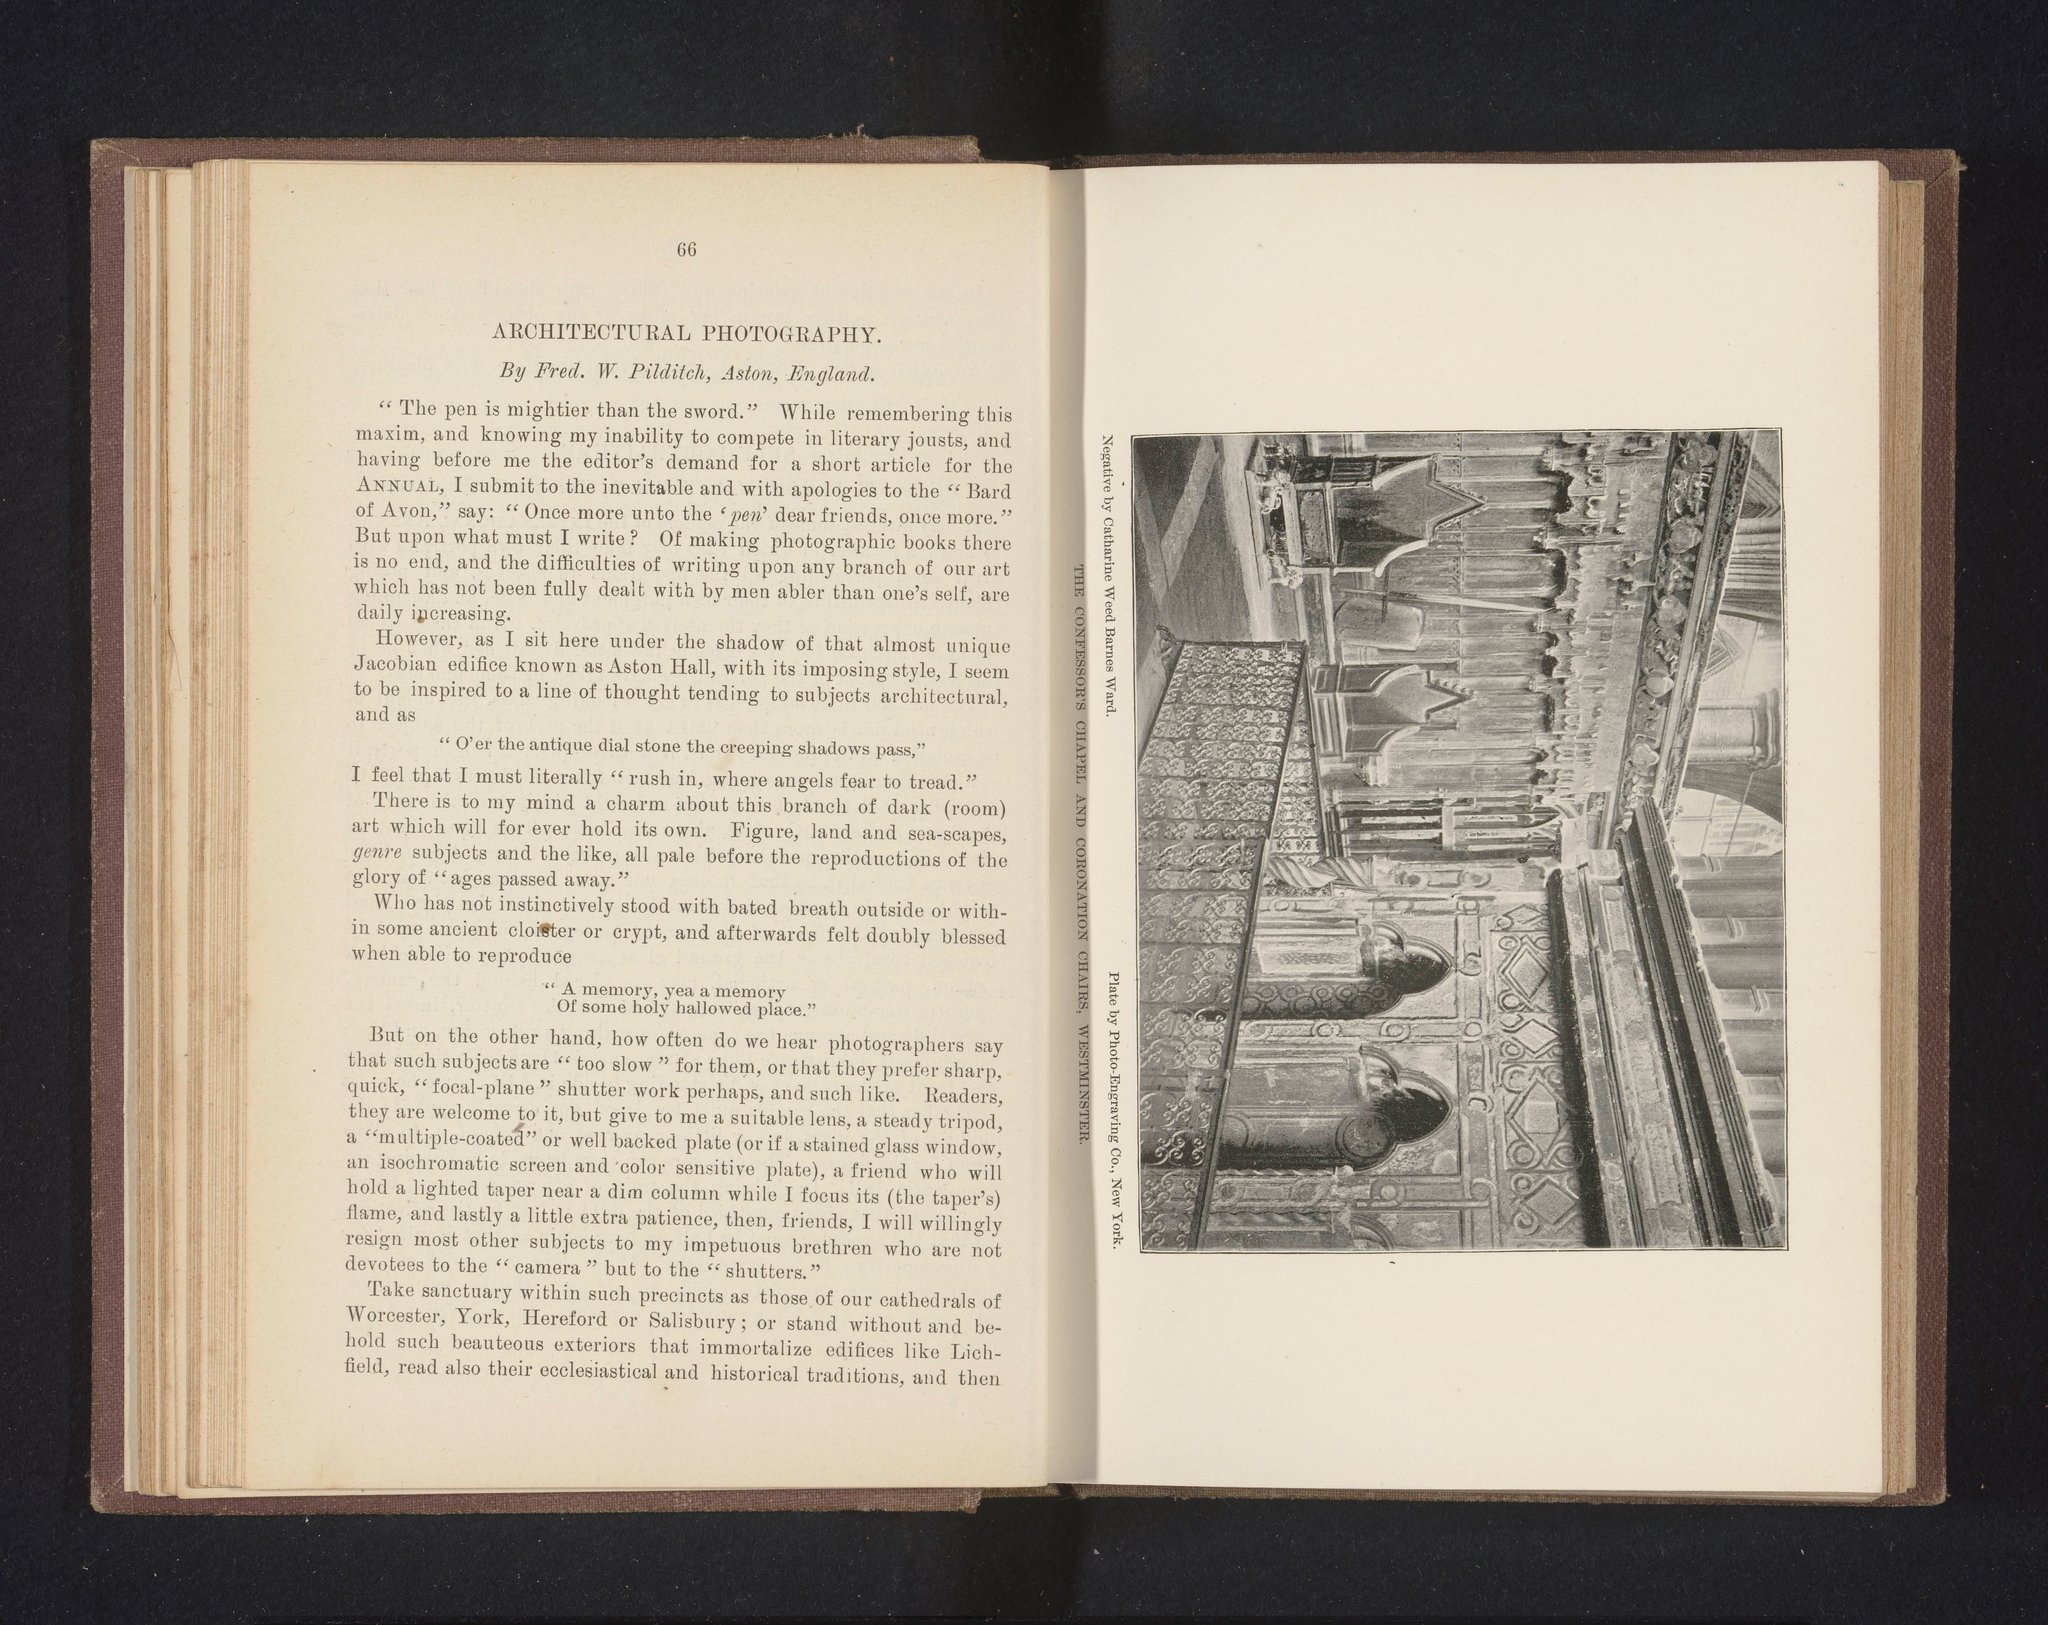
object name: photomechanical print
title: The confessor's chapel and coronation chairs, Westminster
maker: catharine weed barnes ward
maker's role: fotograaf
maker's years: 1851-1913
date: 1888-1893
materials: paper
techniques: autotype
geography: new york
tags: interior of church